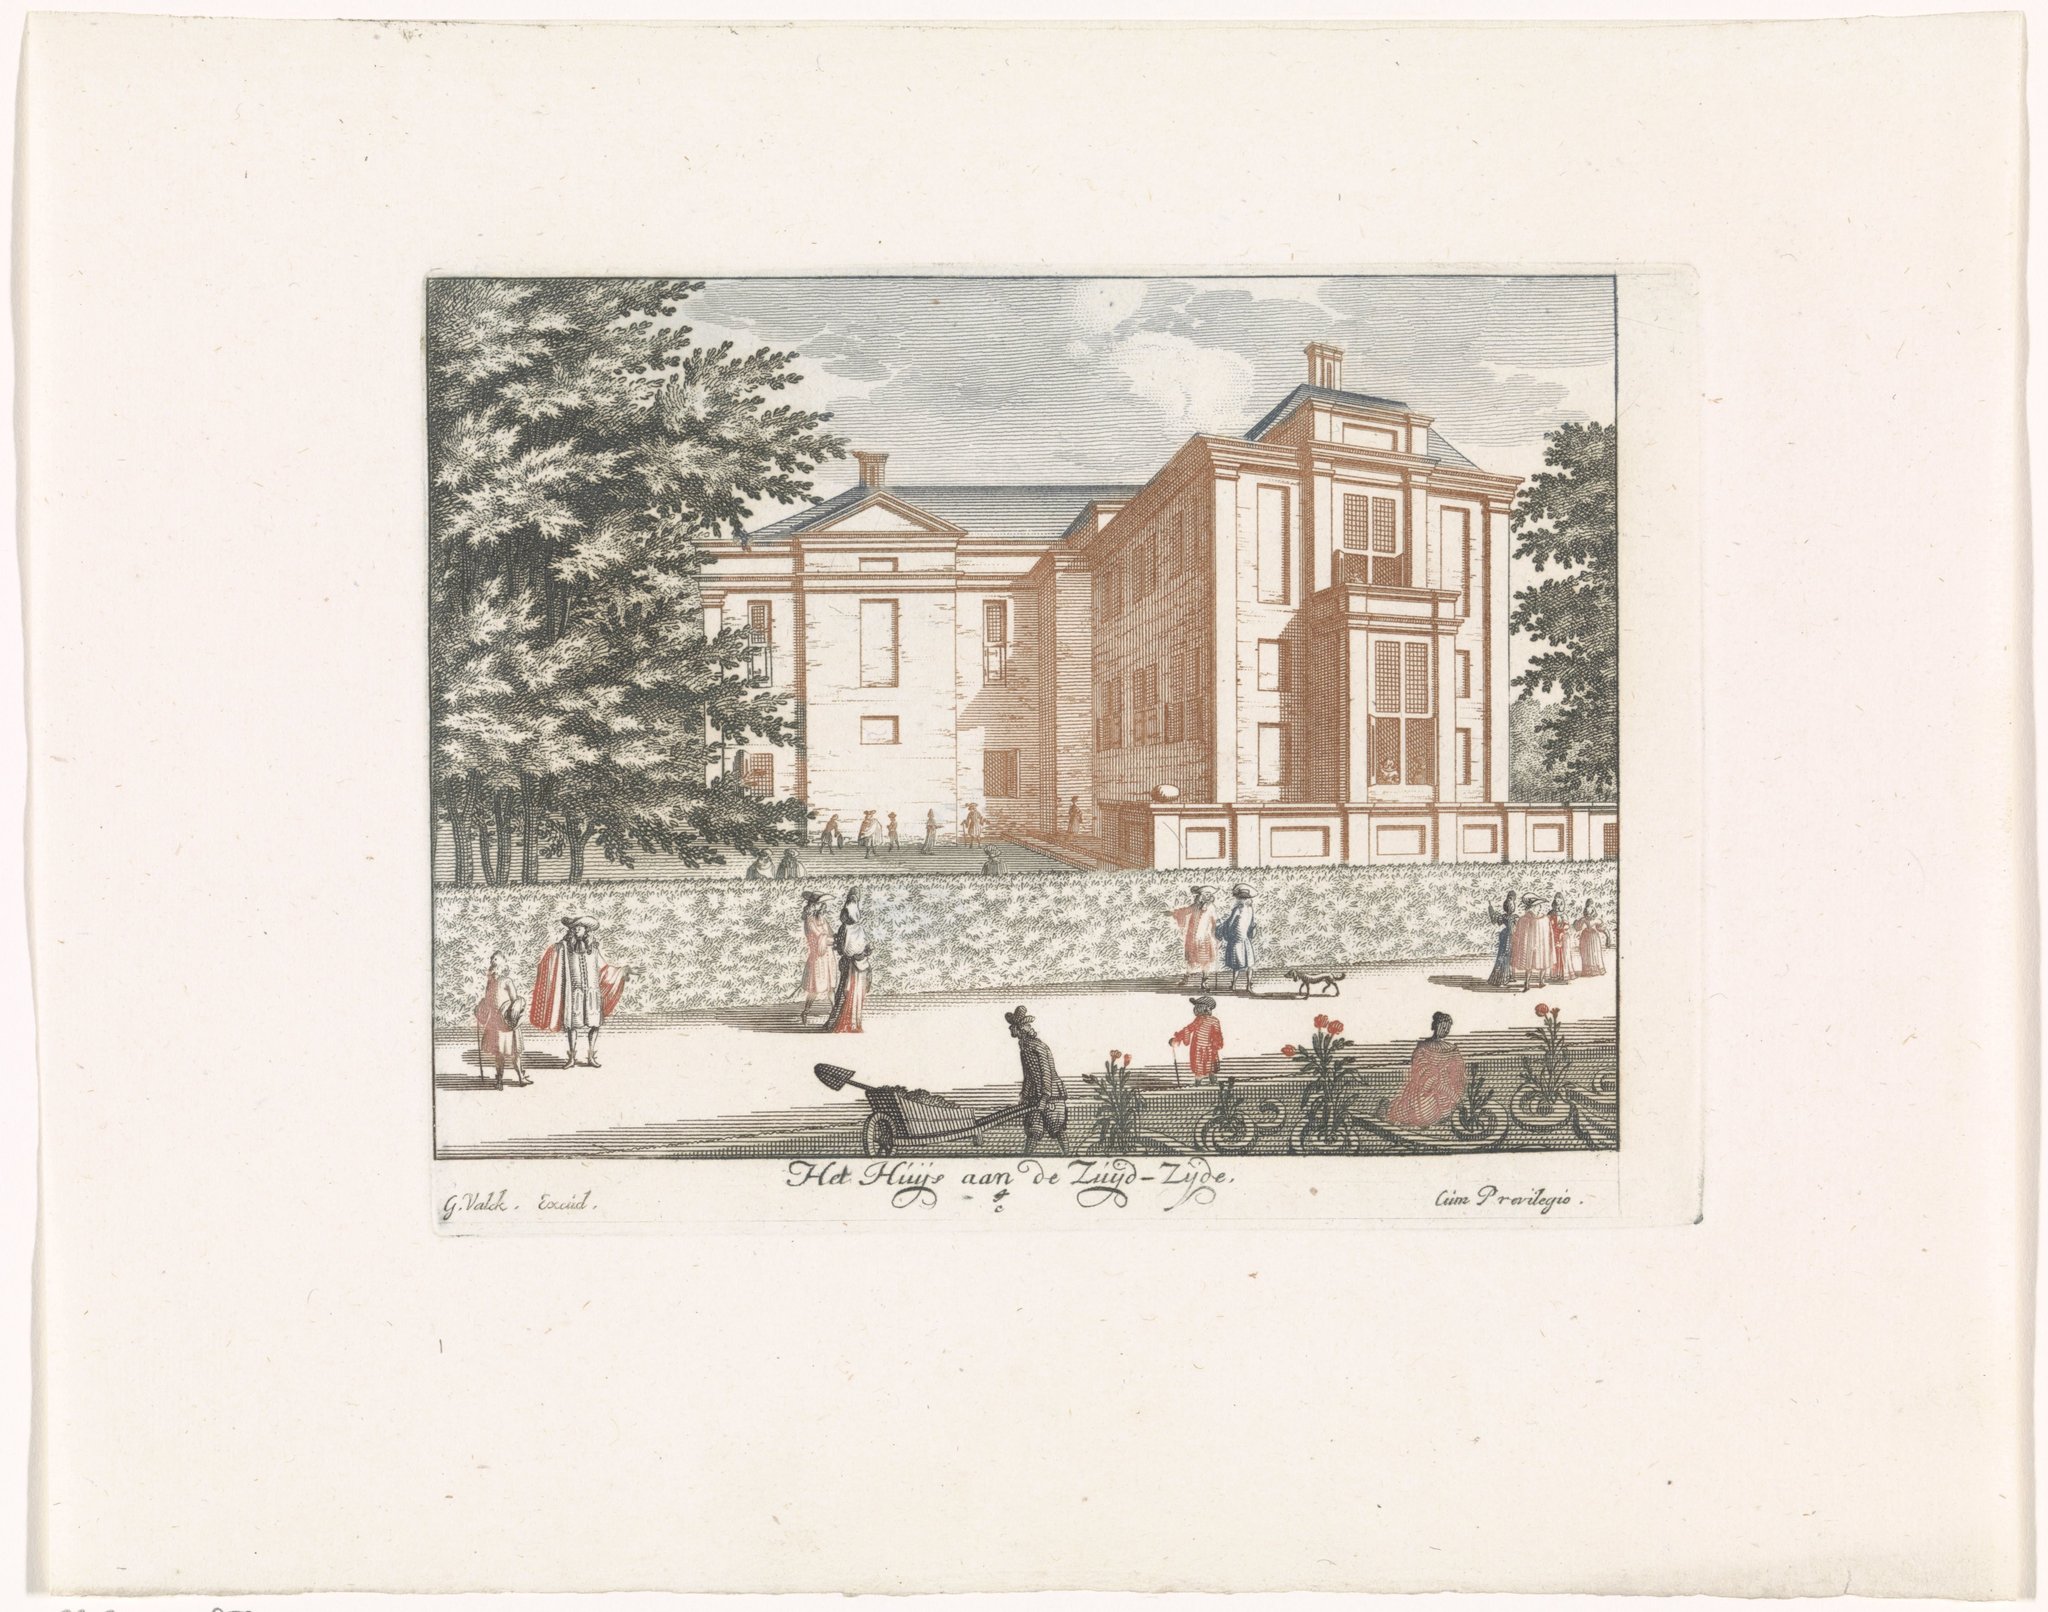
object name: print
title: Veues et perspectives de Soesdyck, chasteau & maison de plaisance du roy de la Grande Bretagne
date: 1695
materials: paper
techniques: etching, lithography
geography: amsterdam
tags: the hague, william iii (prince of orange and king of england, scotland, and ireland), representation of real building (either existing or having existed)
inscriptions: collector's mark: Lugt 2760, collector's mark: Lugt 2228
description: Zuidzijde van Paleis Soestdijk, jachtslot van stadhouder Willem III van Oranje-Nassau. Op de voorgrond figuren op de weg en een man met een kruiwagen in de tuin.